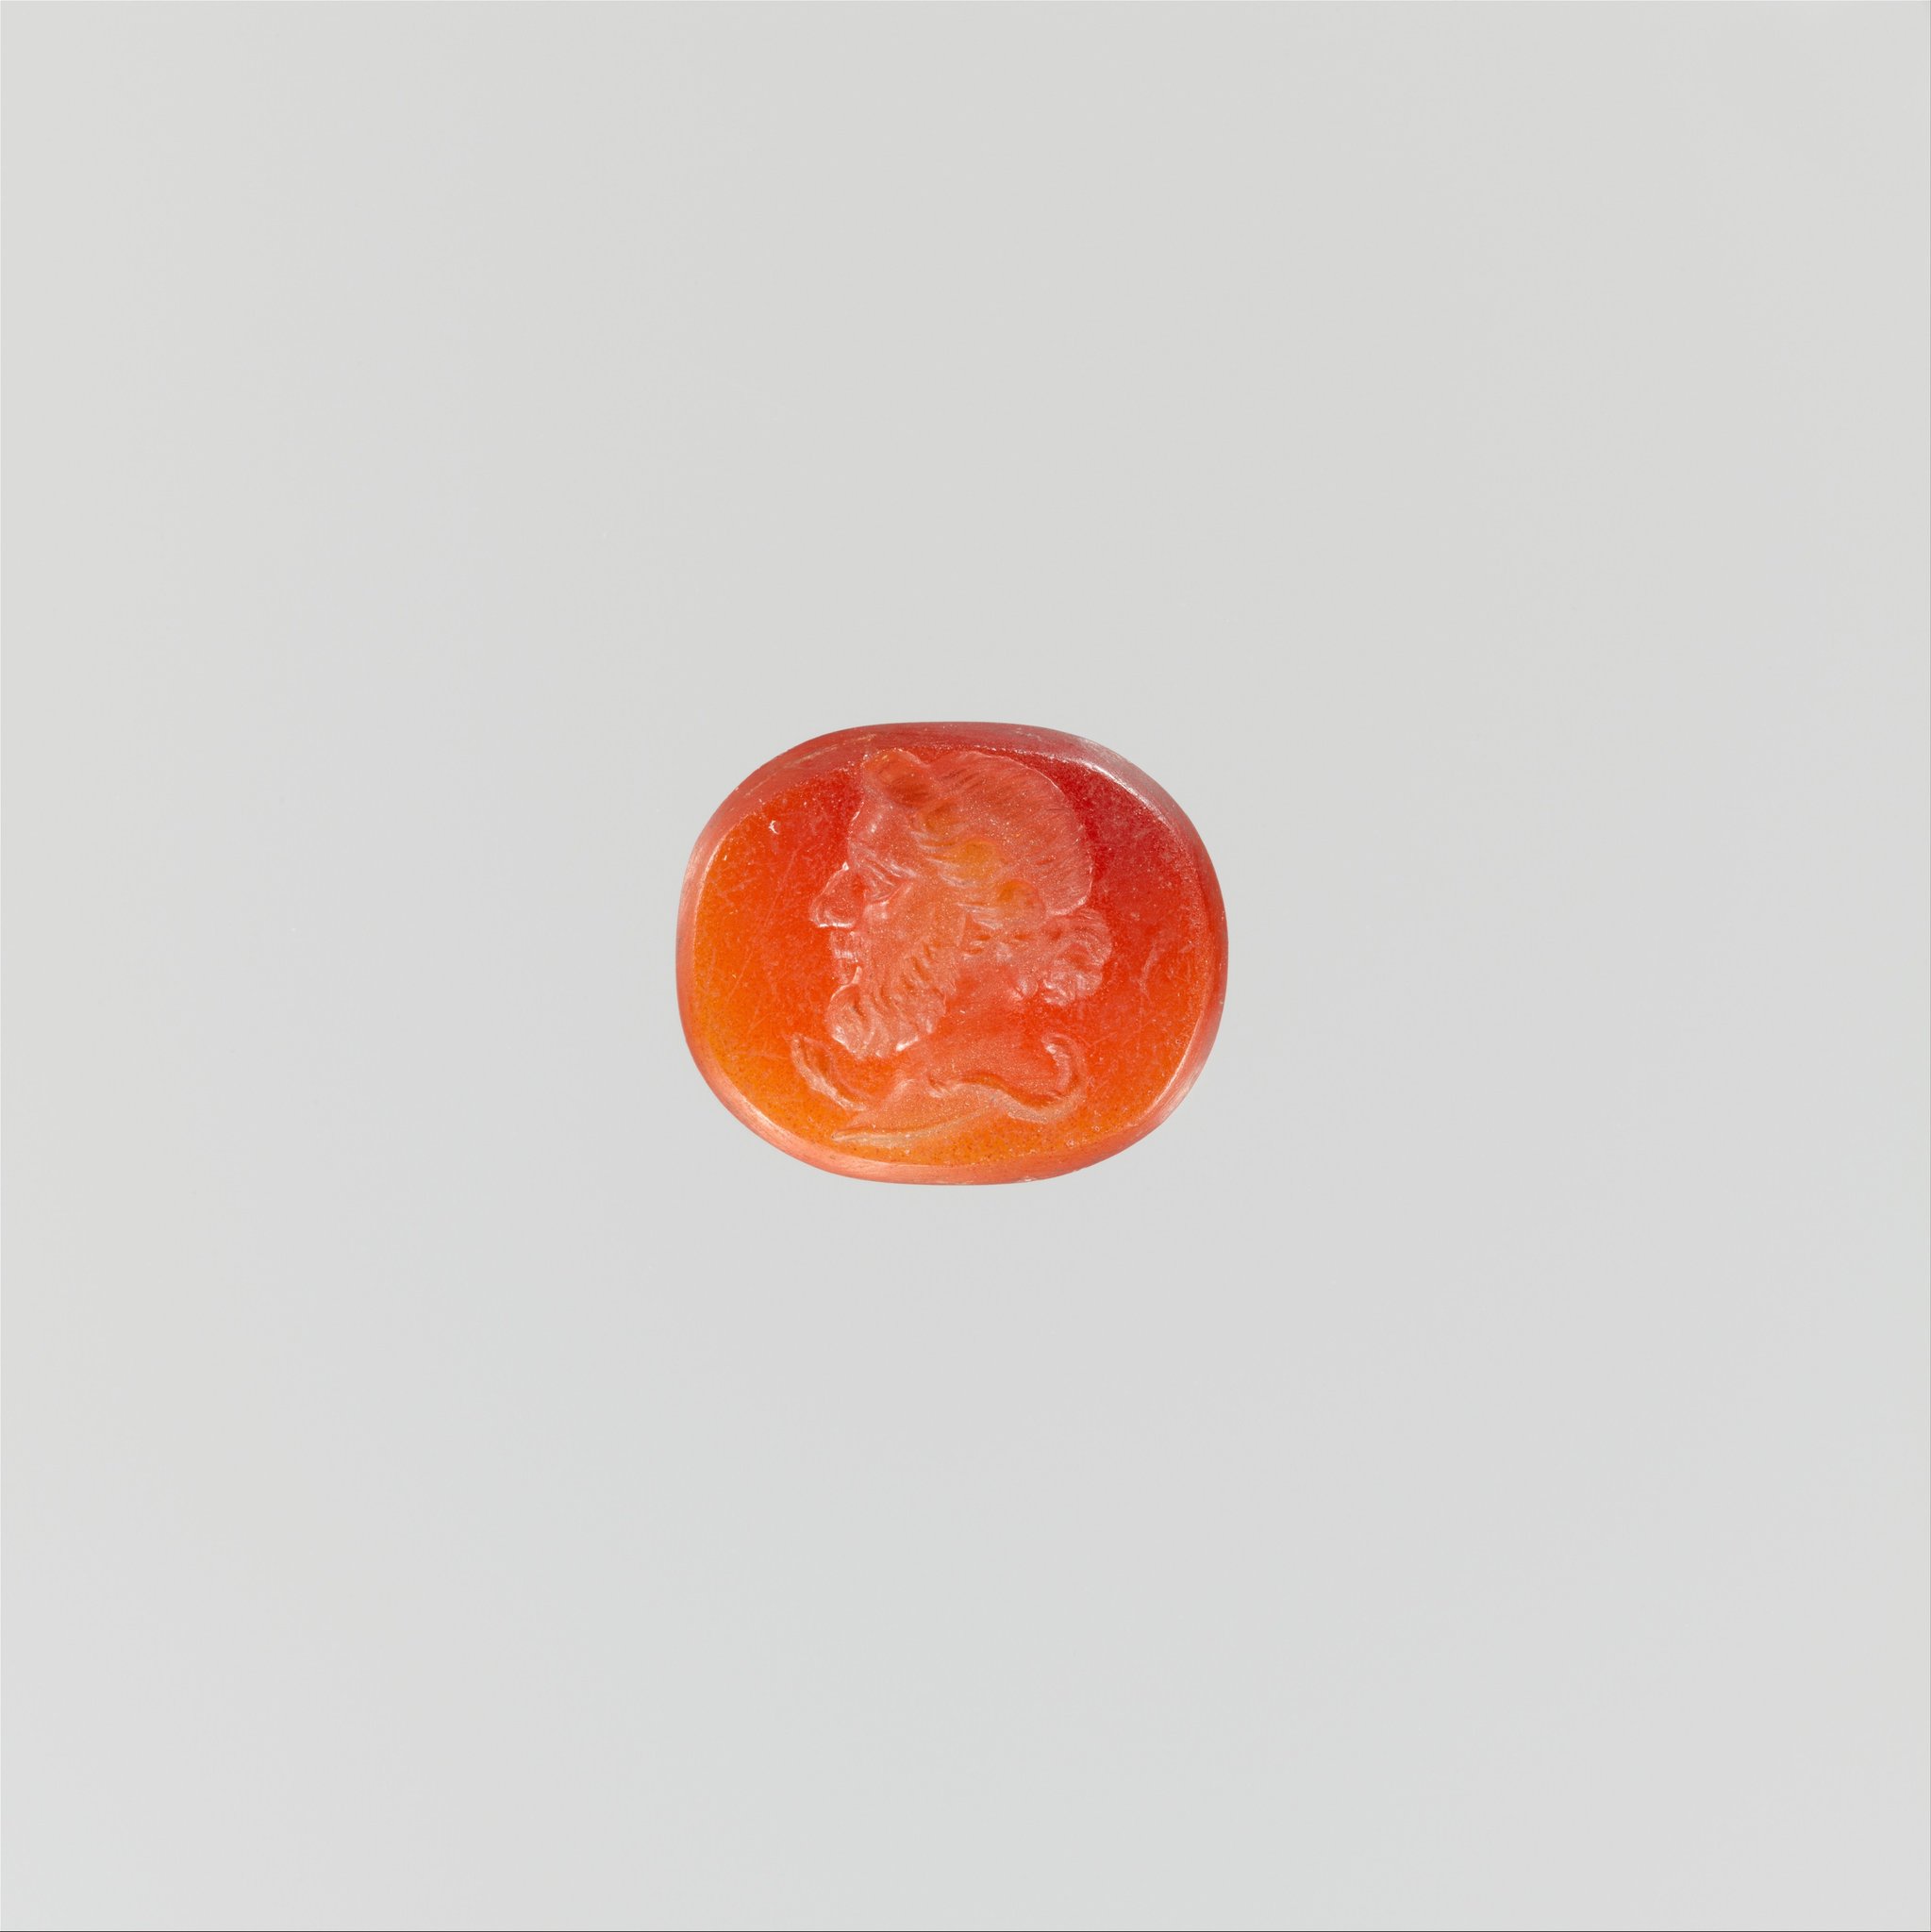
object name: intaglio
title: Carnelian ring stone with Asclepius, the god of medicine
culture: roman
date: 1-100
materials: gemstone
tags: men